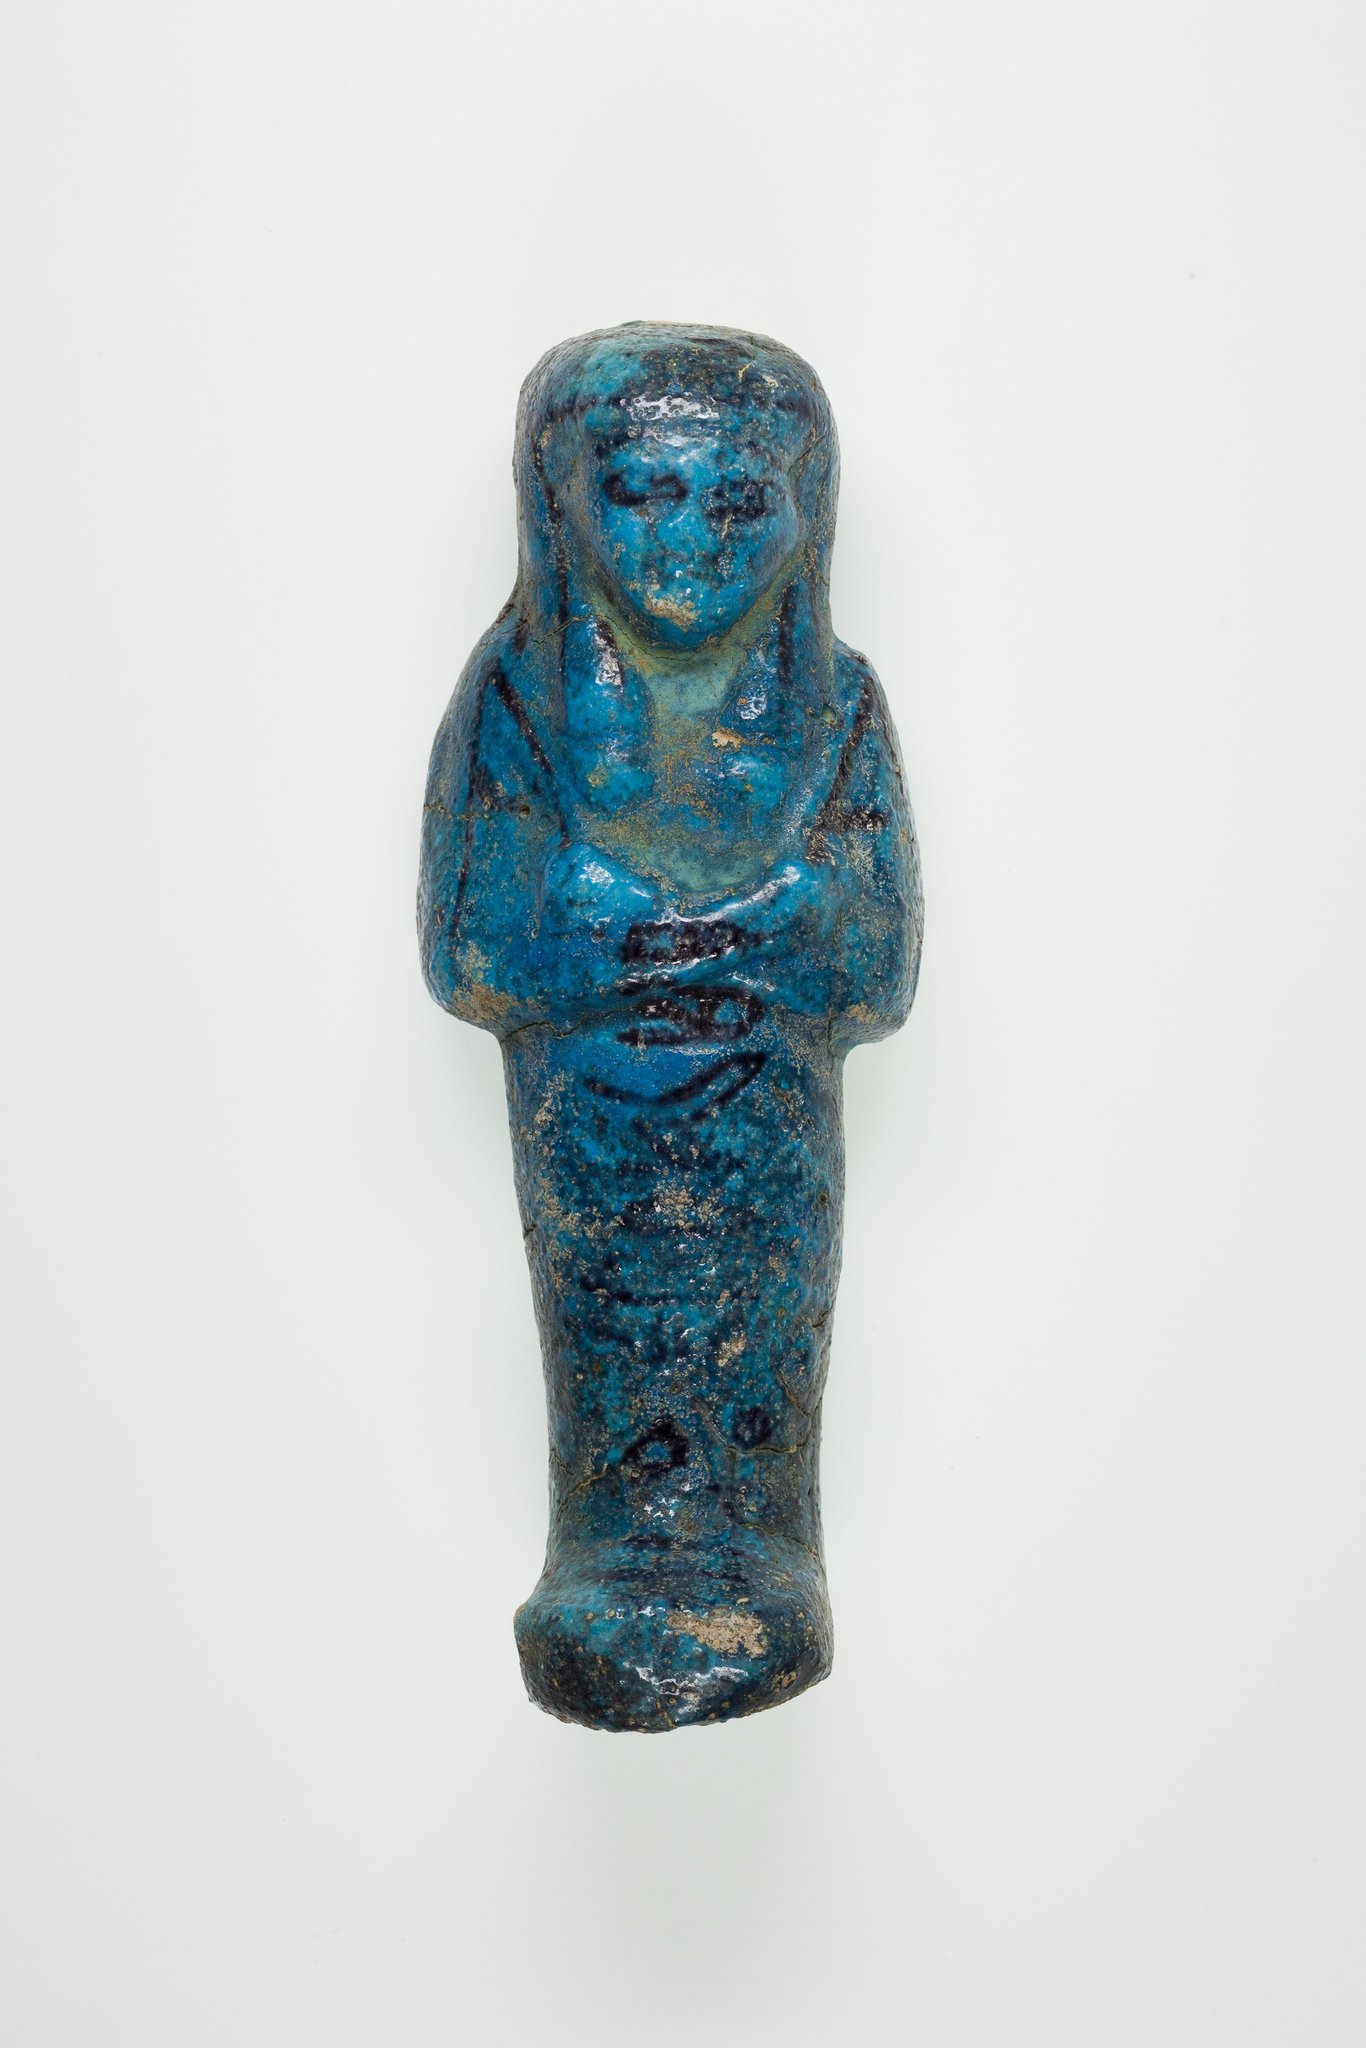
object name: shabti, henettawy c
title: Worker Shabti of Henettawy (C), Daughter of Isetemkheb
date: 990-970 BCE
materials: faience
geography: egypt